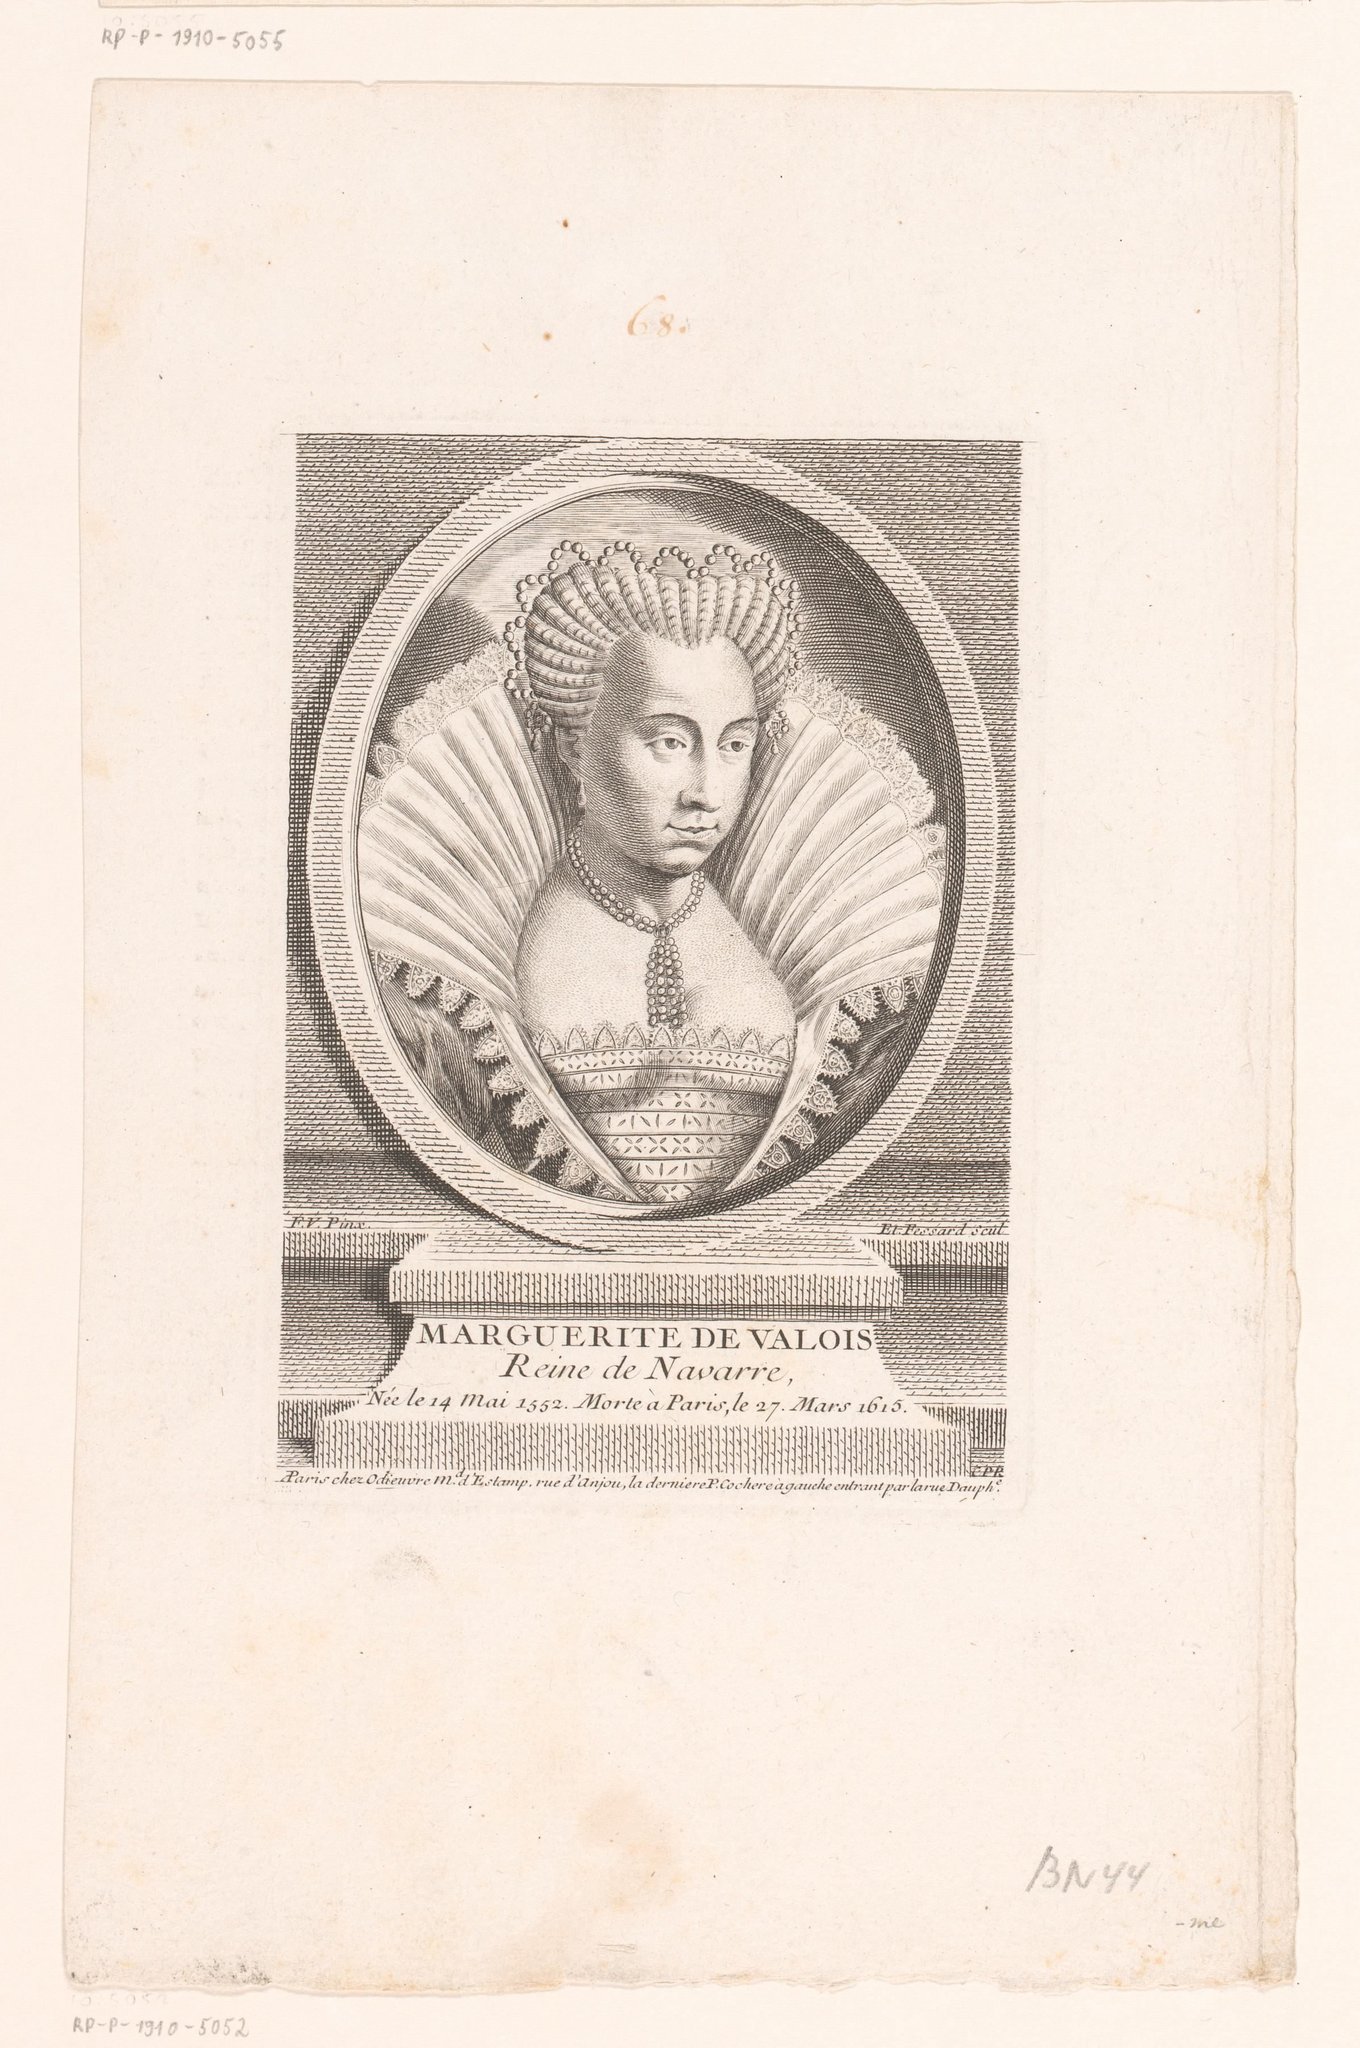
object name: book illustration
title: Portret van Margaretha van Valois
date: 1743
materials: paper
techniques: engraving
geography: paris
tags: historical persons - bb - woman, ornament ~ medallion, ruler, sovereign - bb - female ruler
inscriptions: inscription: ‘68.’, collector's mark: Lugt 2228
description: Prent uit: Dreux du Radier, Jean-François. L'Europe illustré, contenant l'histoire abregée des souverains, des princes, des prélats, des ministres, (...) en Europe: dans le XVe. siècle compris, jusqu'à présent. Parijs: Michel Odieuvre en Jean-Luc Nyon, 1755, dl. 1.